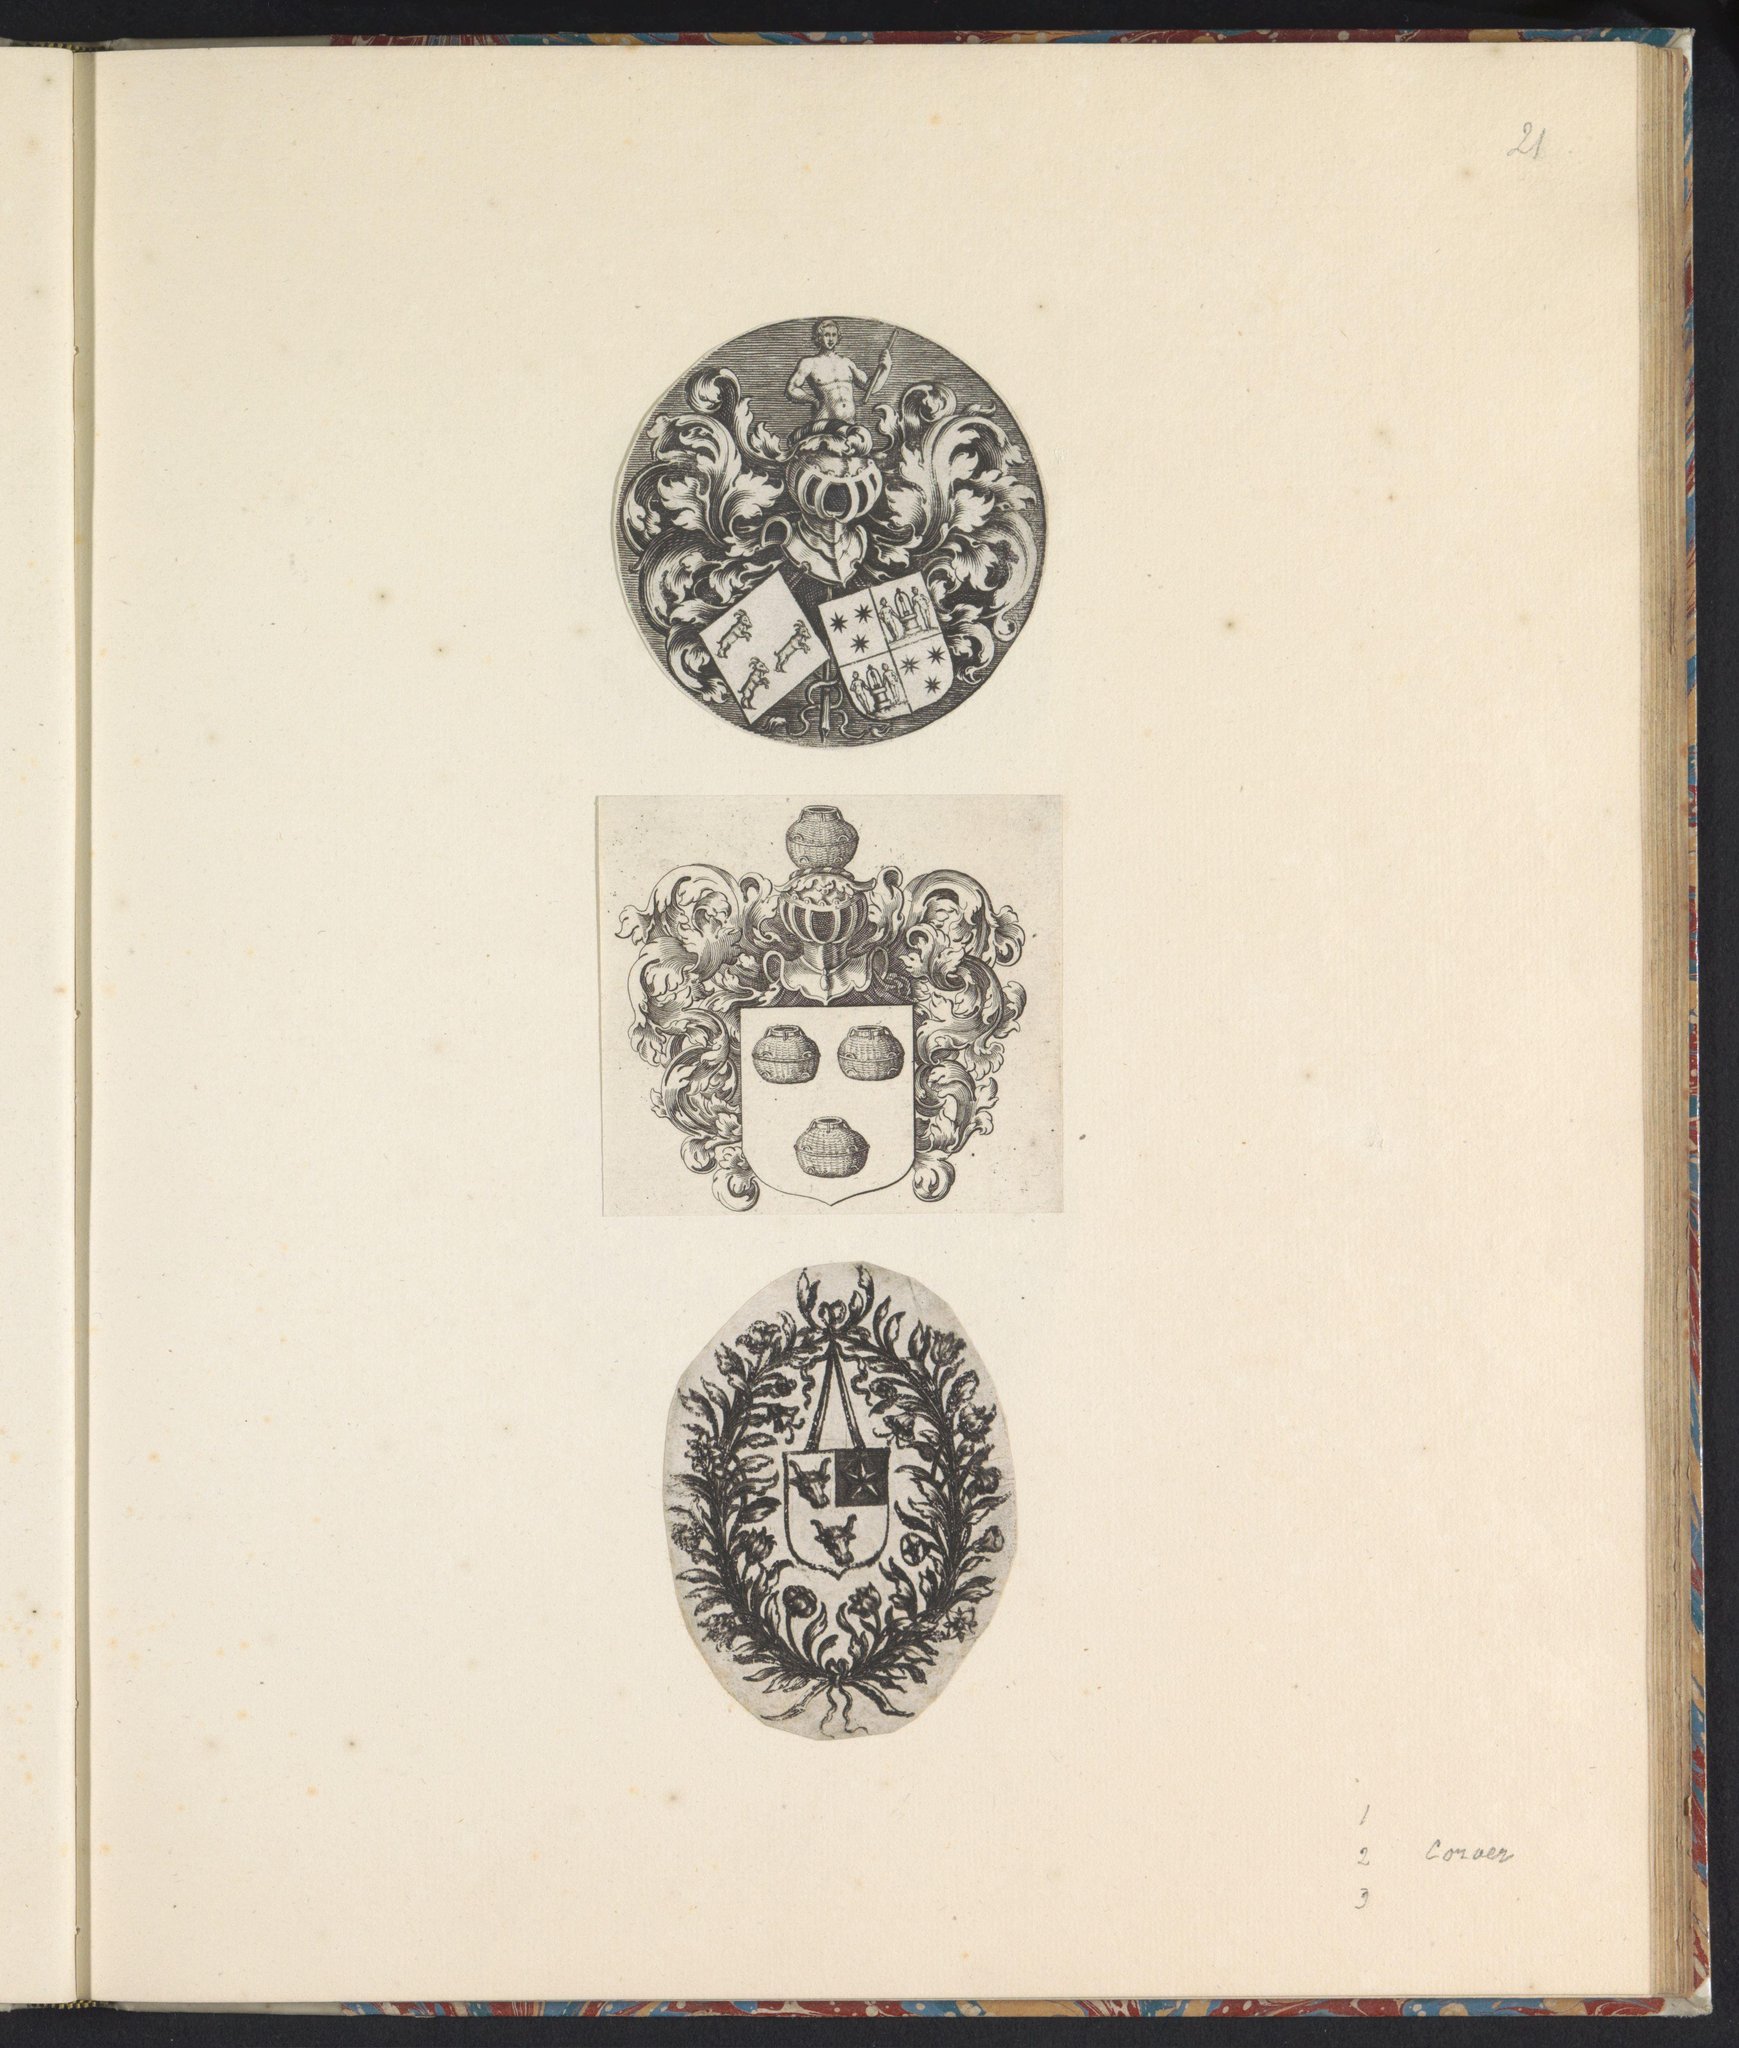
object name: print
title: Drie wapens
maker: Anonymous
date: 1600-1699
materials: paper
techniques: engraving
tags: armorial bearing, heraldry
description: Drie voorstellingen op een albumblad. Bovenaan een wapen met dubbel schild. Op de schilden drie bokken, sterren en twee mensen bij een waterput. Het linker schild met de drie bokken verwijst mogelijk naar de familie Van Zanten. Daaronder een wapen met drie manden op een schild. Onderaan een wapenschild binnen een bloemenkrans. Op het schild een ster en twee ossenkoppen. De prenten maken deel uit van een album.